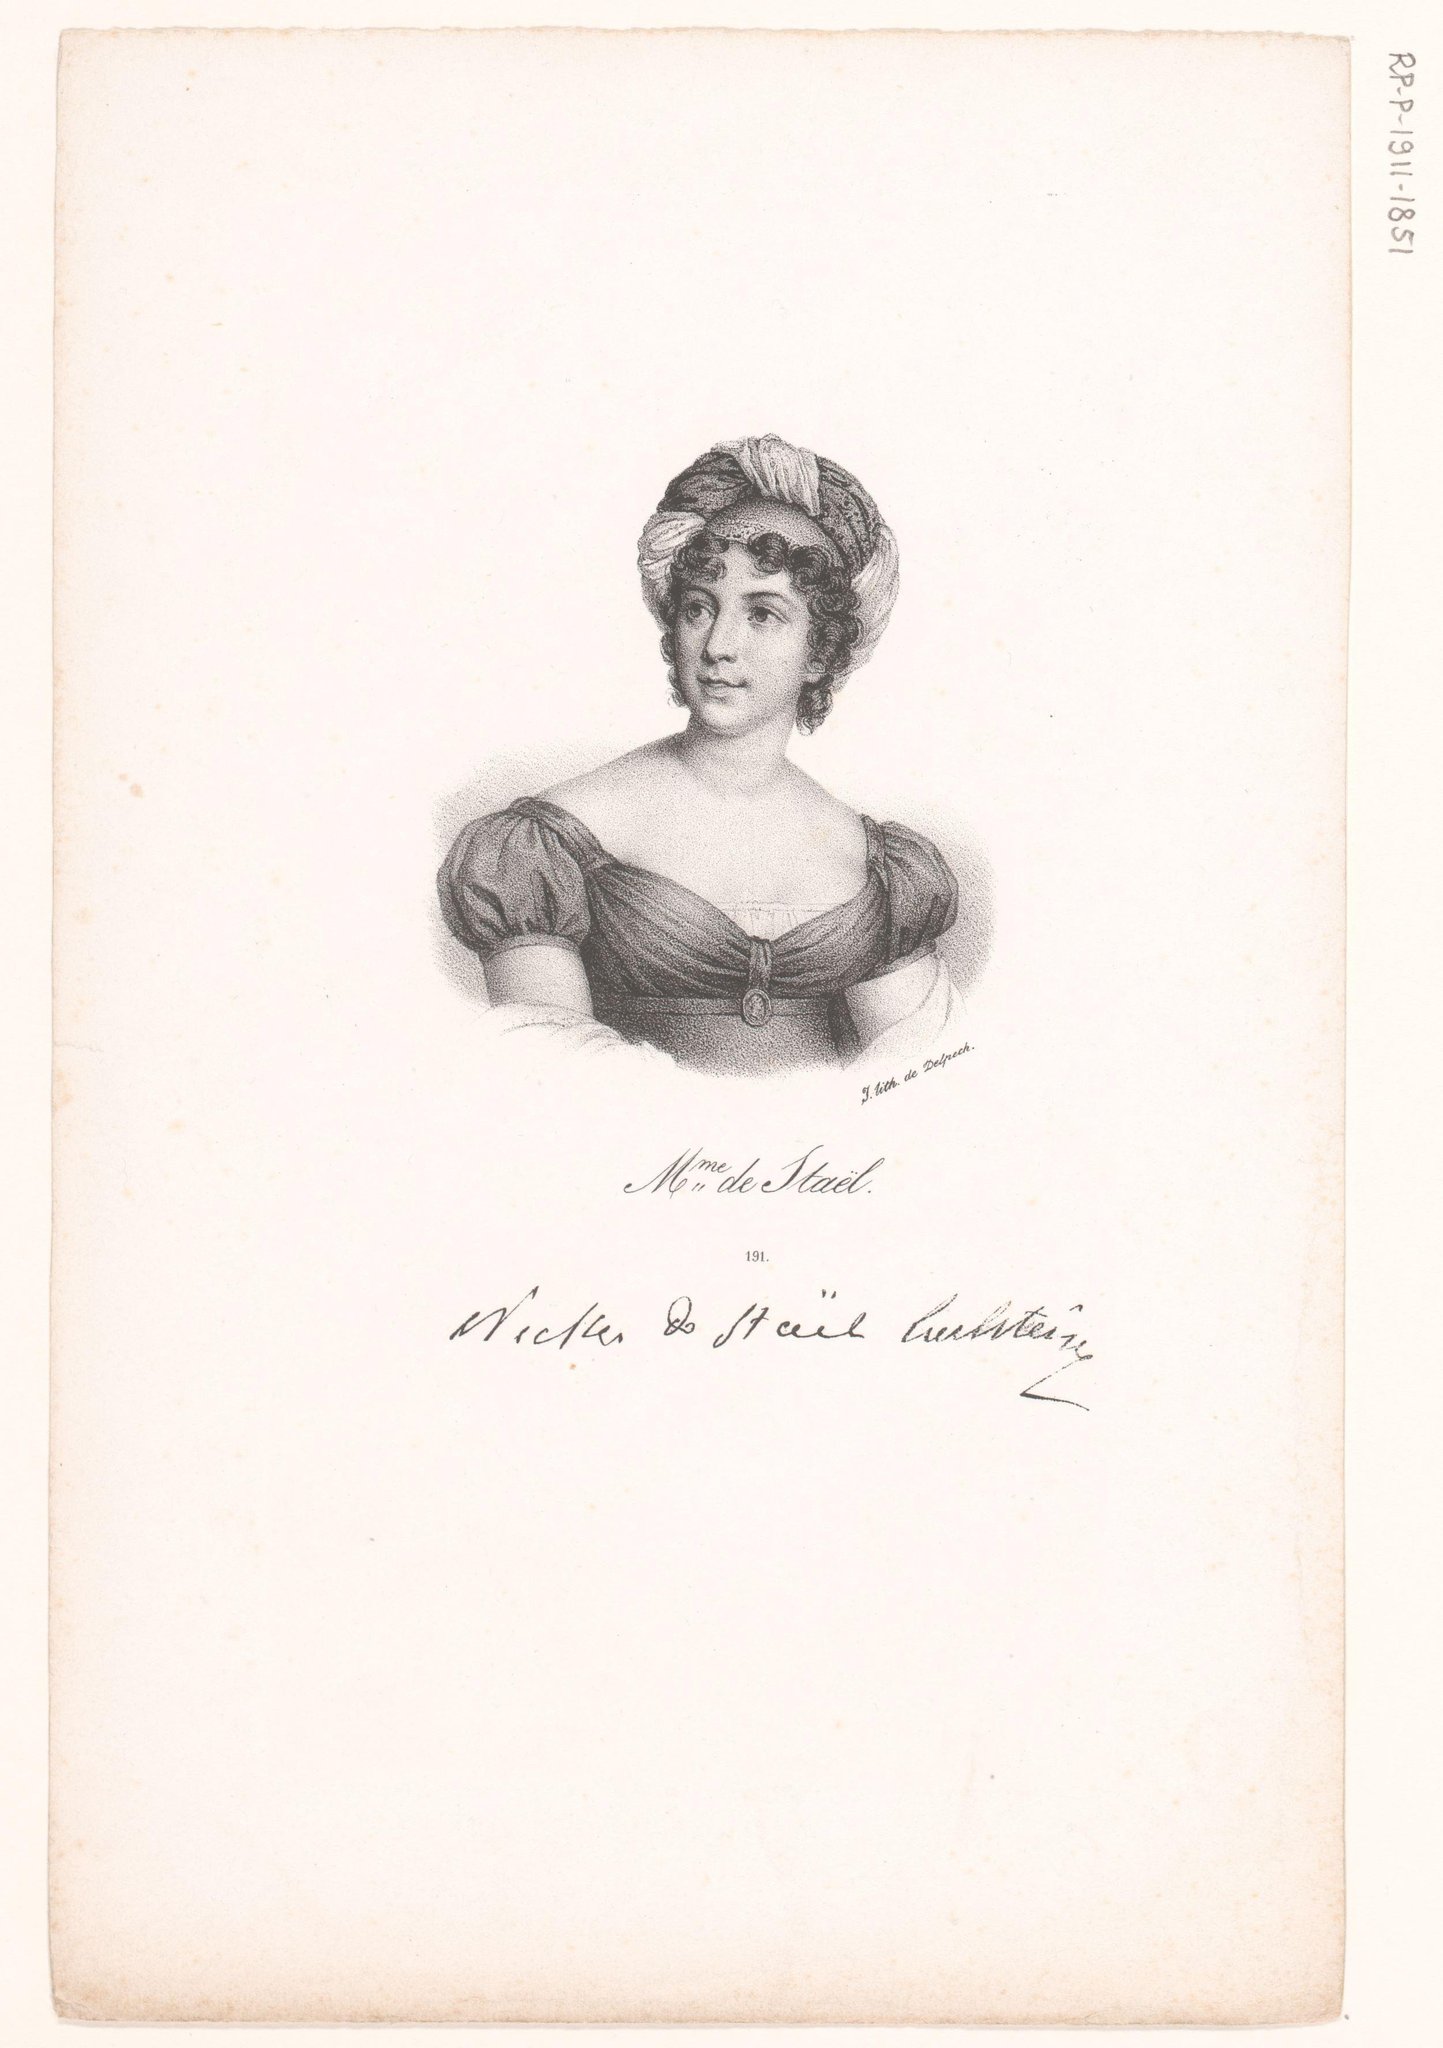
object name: print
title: Portret van Germaine de Staël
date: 1818-1842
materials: paper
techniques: lithograph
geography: paris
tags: historical persons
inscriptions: collector's mark: Lugt 2228a